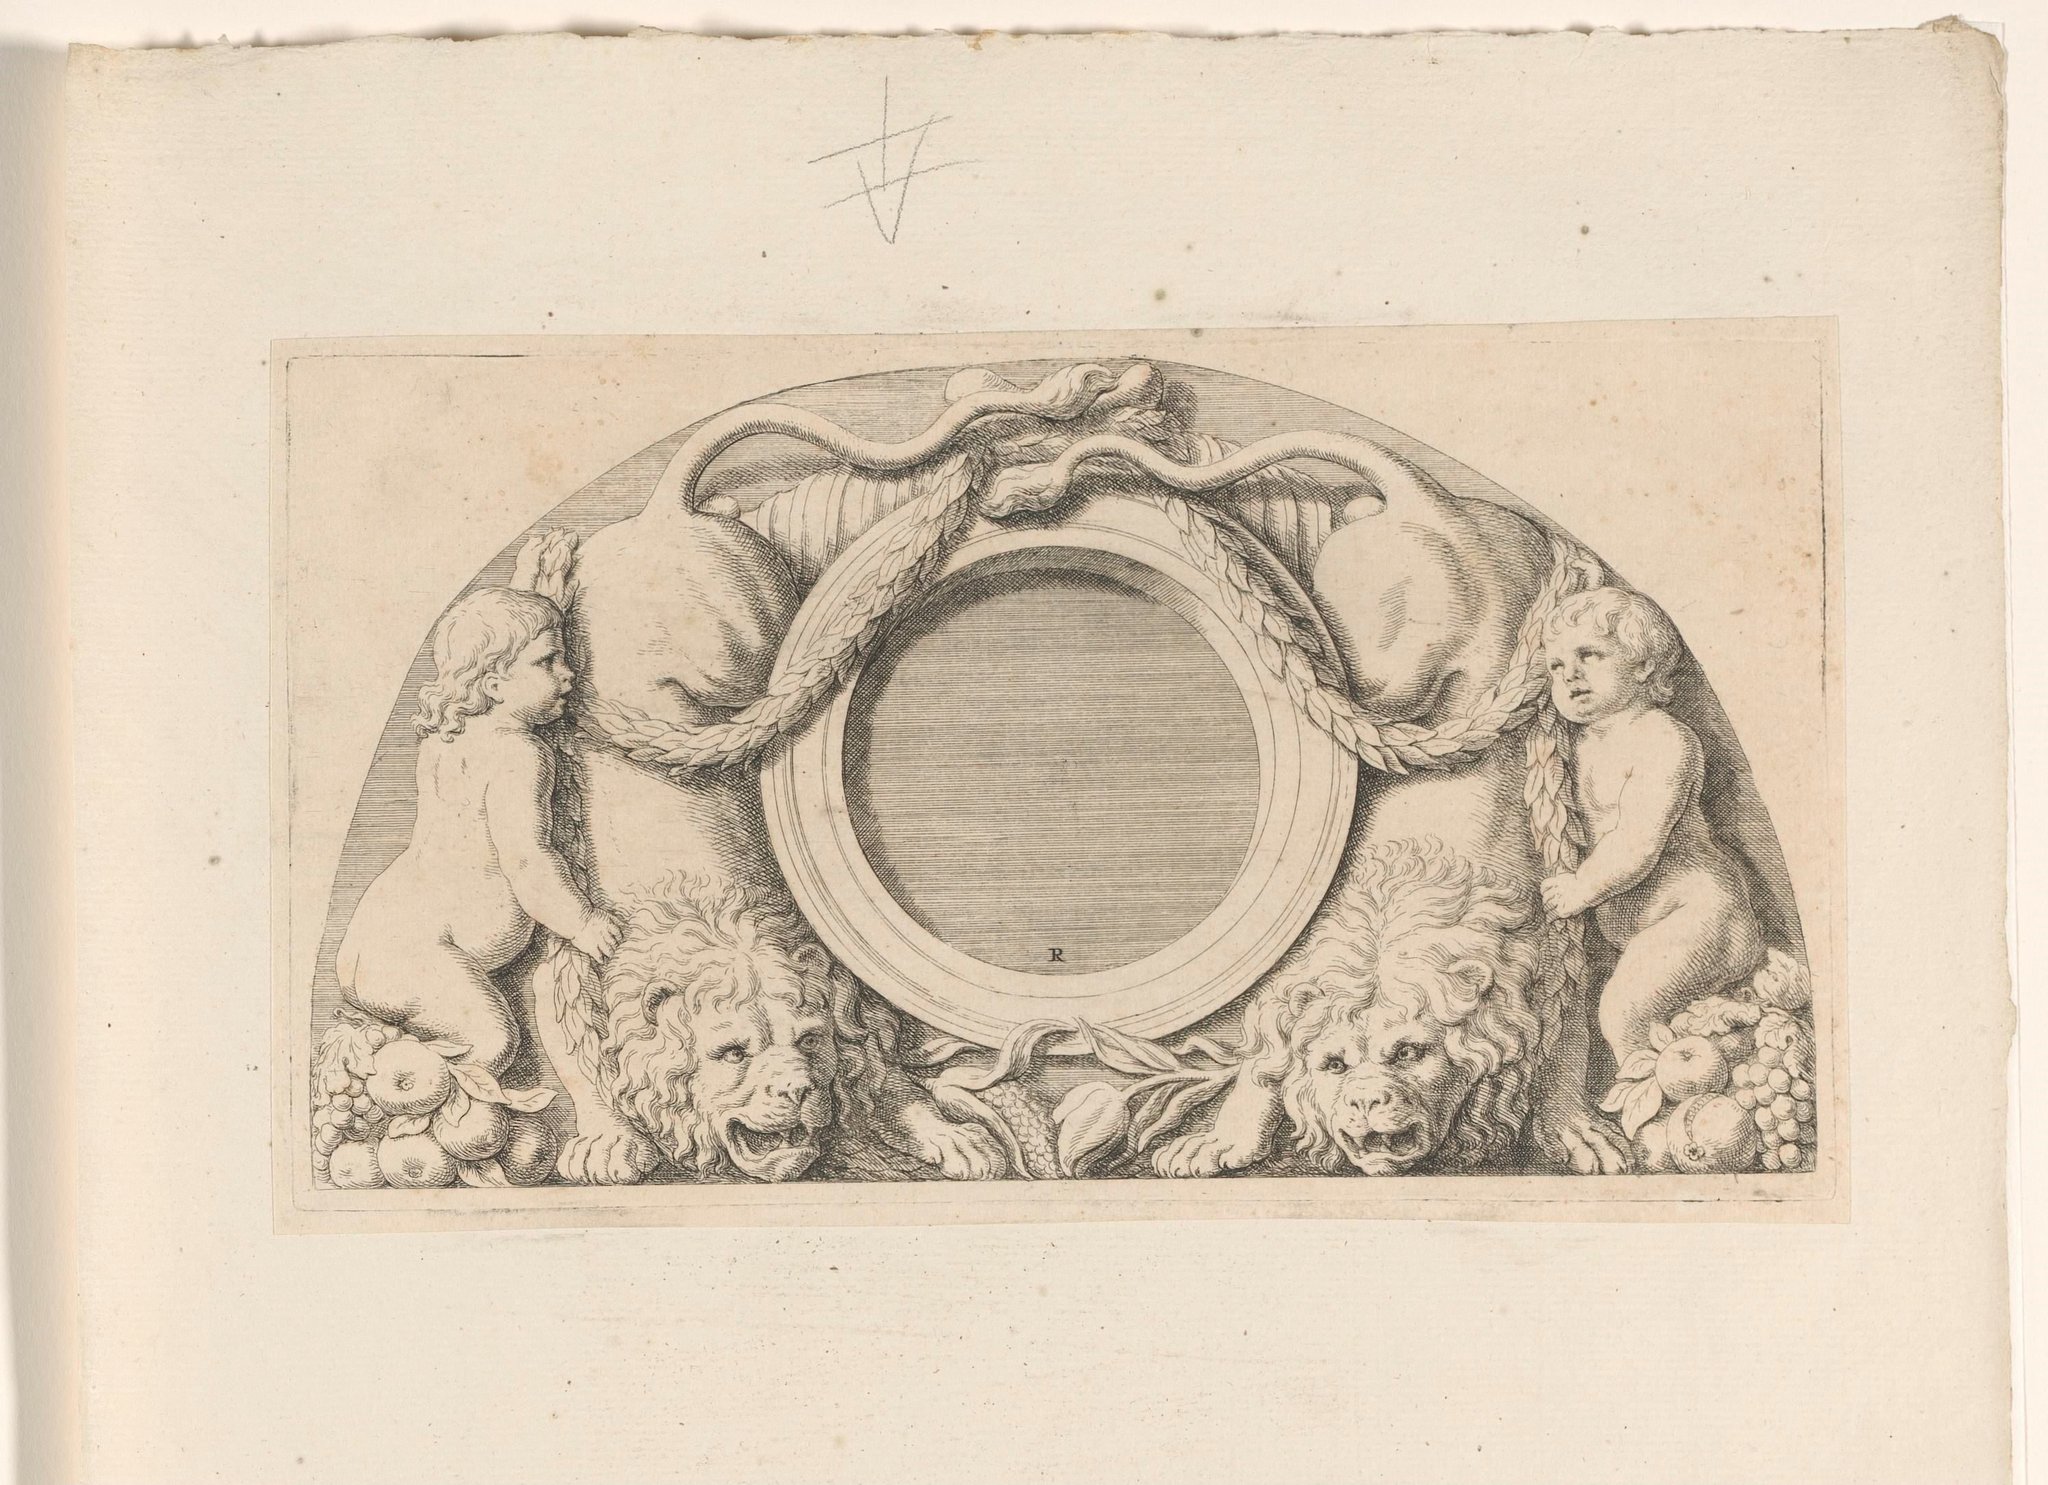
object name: print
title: Lunette met putti, leeuwen en hoornen des overvloeds in de oostelijke galerij van het Stadhuis op de Dam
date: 1655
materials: paper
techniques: engraving, etching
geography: amsterdam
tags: 'cornucopia', horn of plenty, beasts of prey, predatory animals: lion, cupids: 'amores', 'amoretti', 'putti', attributes of cybele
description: Prent gebruikt in: Prima pars. Praecipuarum effigierum ac ornamentorum, amplissimae Curiae Amstelrodamensis (…) / Het eerste deel. Van de voornaemste Statuen ende Ciraten, vant konstijck Stadhuys van Amstelredam, tmeeste in marmer gemaeckt, door Artus Quellinus, Beelthouwer der voorseyde Stadt / La Premier Partie. De plusieurs Figures et ornements, de la Maison de Ville d'Amsterdam (…). Amsterdam: Artus Quellinus (I), 1655. Zie RP-P-AO-22-1-1 voor bijhorende titelpagina. Zie RP-P-AO-22-1-2 voor bijhorend register. Zie RP-P-AO-22-1A, RP-P-AO-22-1B, RP-P-AO-22-1C, RP-P-AO-22-1D-1, RP-P-AO-22-1D-2, RP-P-AO-22-1E, RP-P-AO-22-1F, RP-P-AO-22-1G, RP-P-AO-22-1H, RP-P-AO-22-1I, RP-P-AO-22-1K-1, RP-P-AO-22-1K-2, RP-P-AO-22-1K-3, RP-P-AO-22-1K-4, RP-P-AO-22-1K-5, RP-P-AO-22-1L-1, RP-P-AO-22-1L-2, RP-P-AO-22-1M-1, RP-P-AO-22-1M-2, RP-P-AO-22-1N-1, RP-P-AO-22-1N-2, RP-P-AO-22-1N-3, RP-P-AO-22-1N-4, RP-P-AO-22-1N-5, RP-P-AO-22-1O-1, RP-P-AO-22-1O-2, RP-P-AO-22-1O-3, RP-P-AO-22-1O-4, RP-P-AO-22-1P-1, RP-P-AO-22-1P-2, RP-P-AO-22-1P-3, RP-P-AO-22-1P-4, RP-P-AO-22-1Q-1, RP-P-AO-22-1Q-2, RP-P-AO-22-1Q-3, RP-P-AO-22-1Q-4, RP-P-AO-22-1R-1, RP-P-AO-22-1R-3, RP-P-AO-22-1R-4, RP-P-AO-22-1R-5, RP-P-AO-22-1S-1, RP-P-AO-22-1S-2, RP-P-AO-22-1S-3, RP-P-AO-22-1S-4, RP-P-AO-22-1S-5, RP-P-AO-22-1T-1 en RP-P-AO-22-1T-2 voor andere prenten uit deze publicatie. Zelfde staat van prent ook gebruikt in: Prima pars. Praecipuarum effigierum ac ornamentorum, amplissimae Curiae Amstelrodamensis (…) / Het eerste deel. Van de voornaemste Statuen ende Ciraten, vant konstijck Stadhuys van Amstelredam, tmeeste in marmer gemaeckt, door Artus Quellinus, Beelthouwer der voorseyde Stadt / La Premier Partie. De plusieurs Figures et ornements, de la Maison de Ville d'Amsterdam (…). Amsterdam: Frederik de Wit, 1665. Latere staat van prent ook gebruikt in: Architecture peinture et sculpture de la Maison de Ville d'Amsterdam, representee en CIX. figures en taille-douce (…). Amsterdam: David Mortier, 1719. En in: Architecture peinture et sculpture de la Maison de Ville d'Amsterdam, representee en CIX. figures en taille-douce (…). Amsterdam: Gerard Valck, 1719. En in: Bouw schilder en beeldhouwkonst, van het Stadhuis te Amsteldam, vertoont in CIX figuuren (…). Amsterdam: Covens & Mortier & Covens Jr., s.a. (1774-1783).